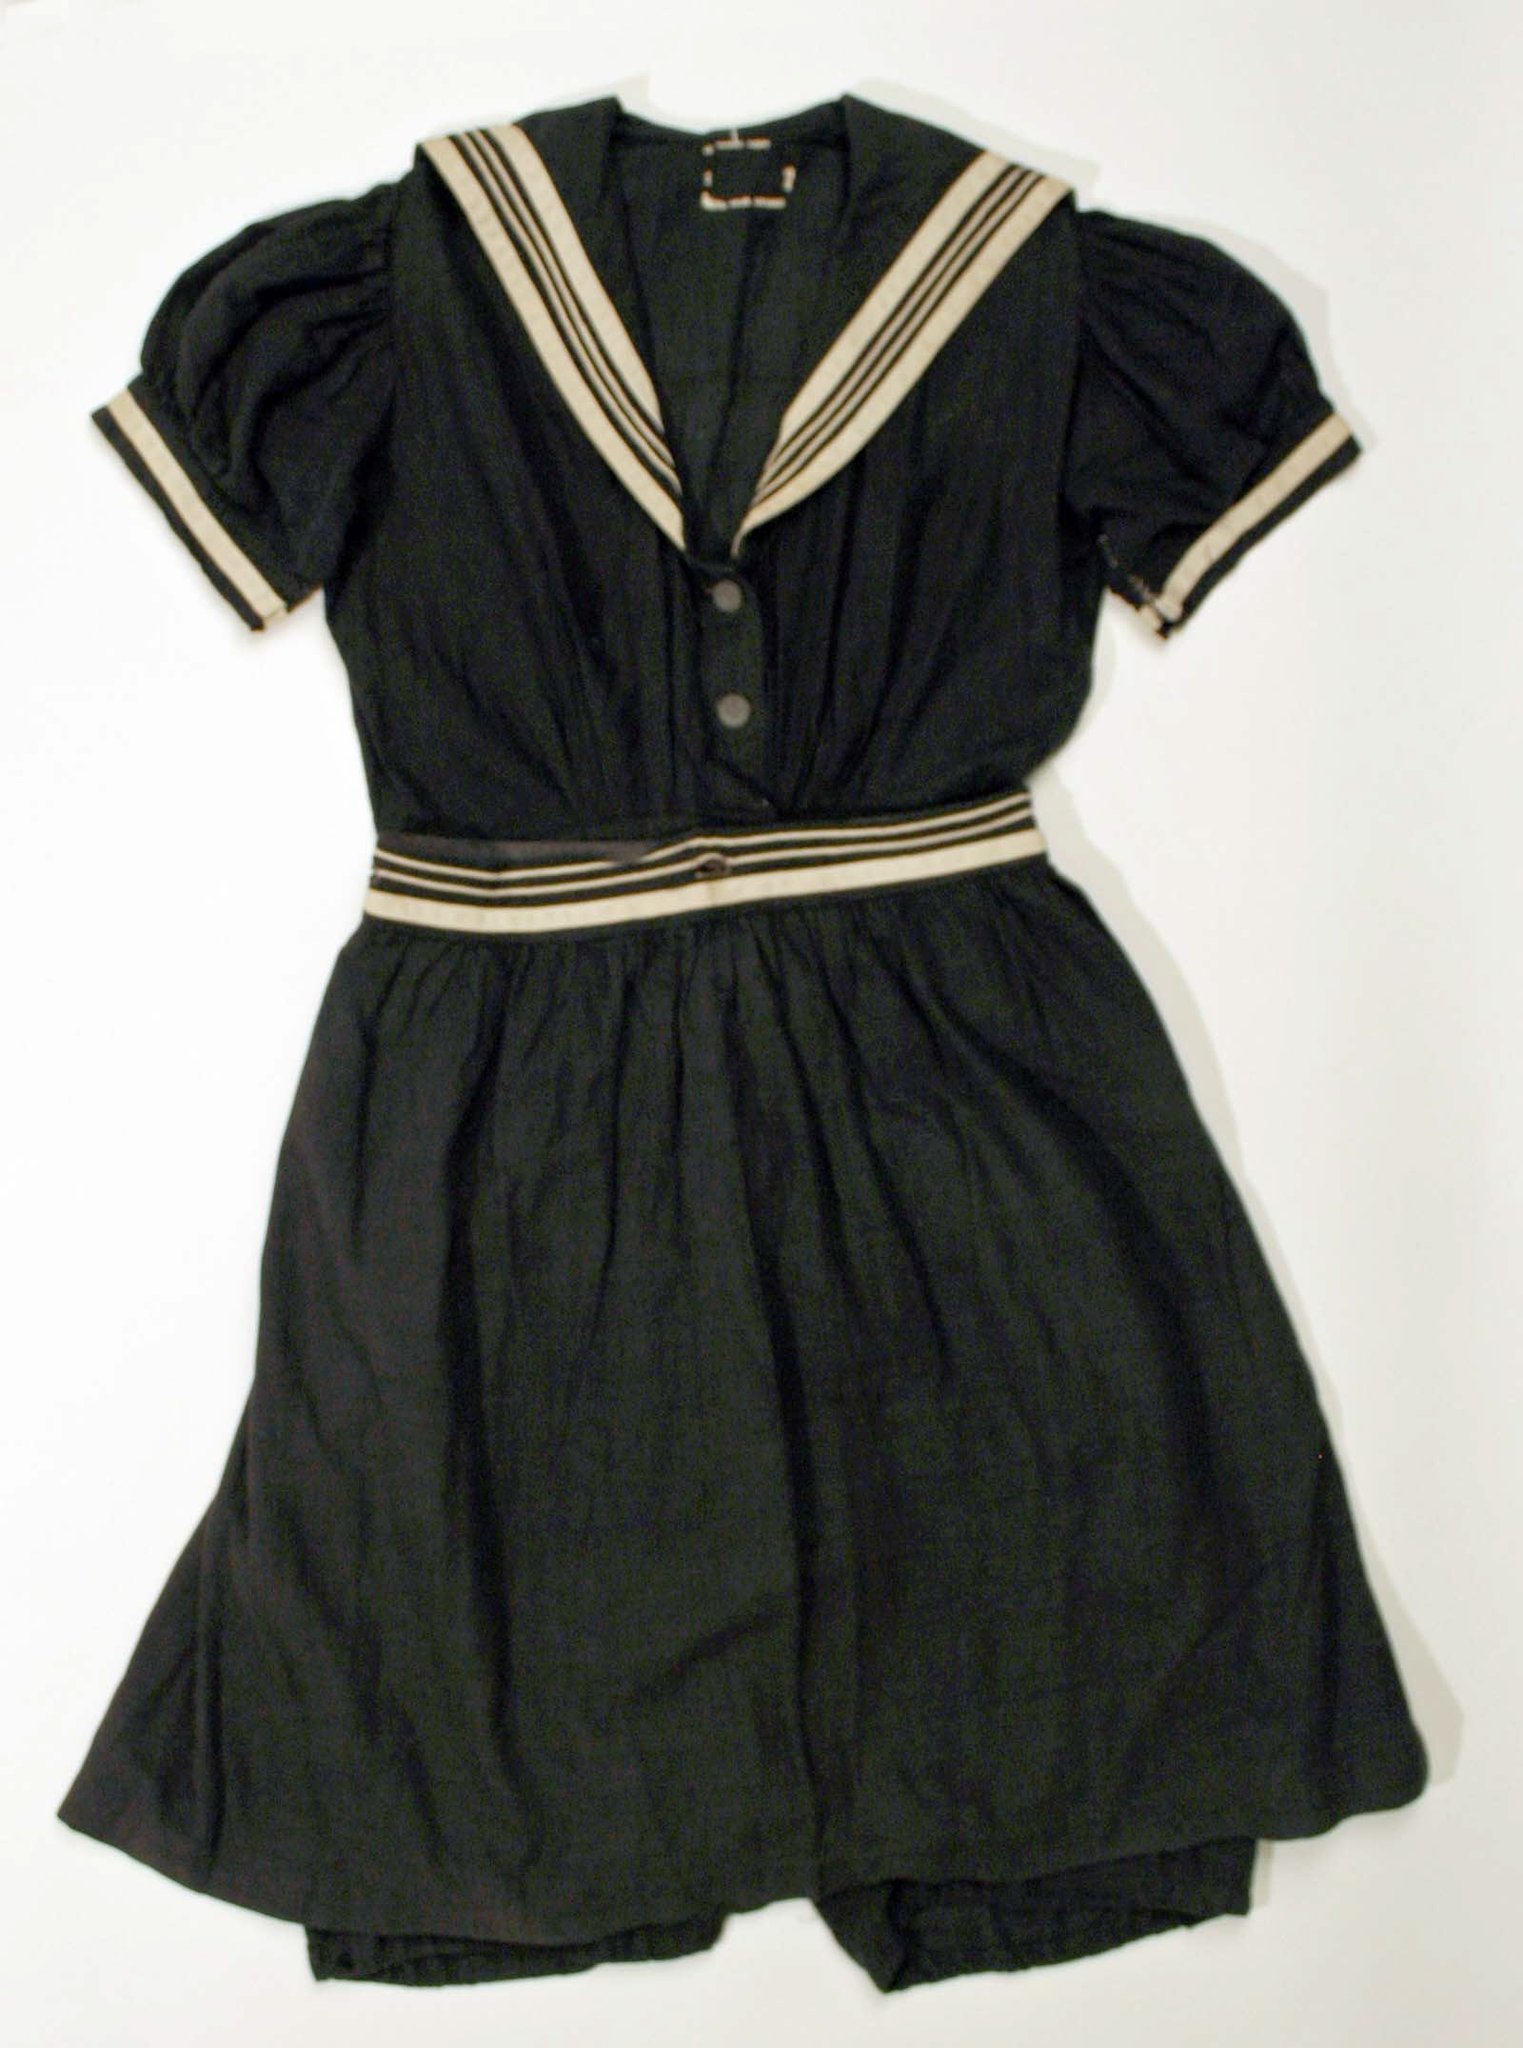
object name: bathing suit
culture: american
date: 1900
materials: wool